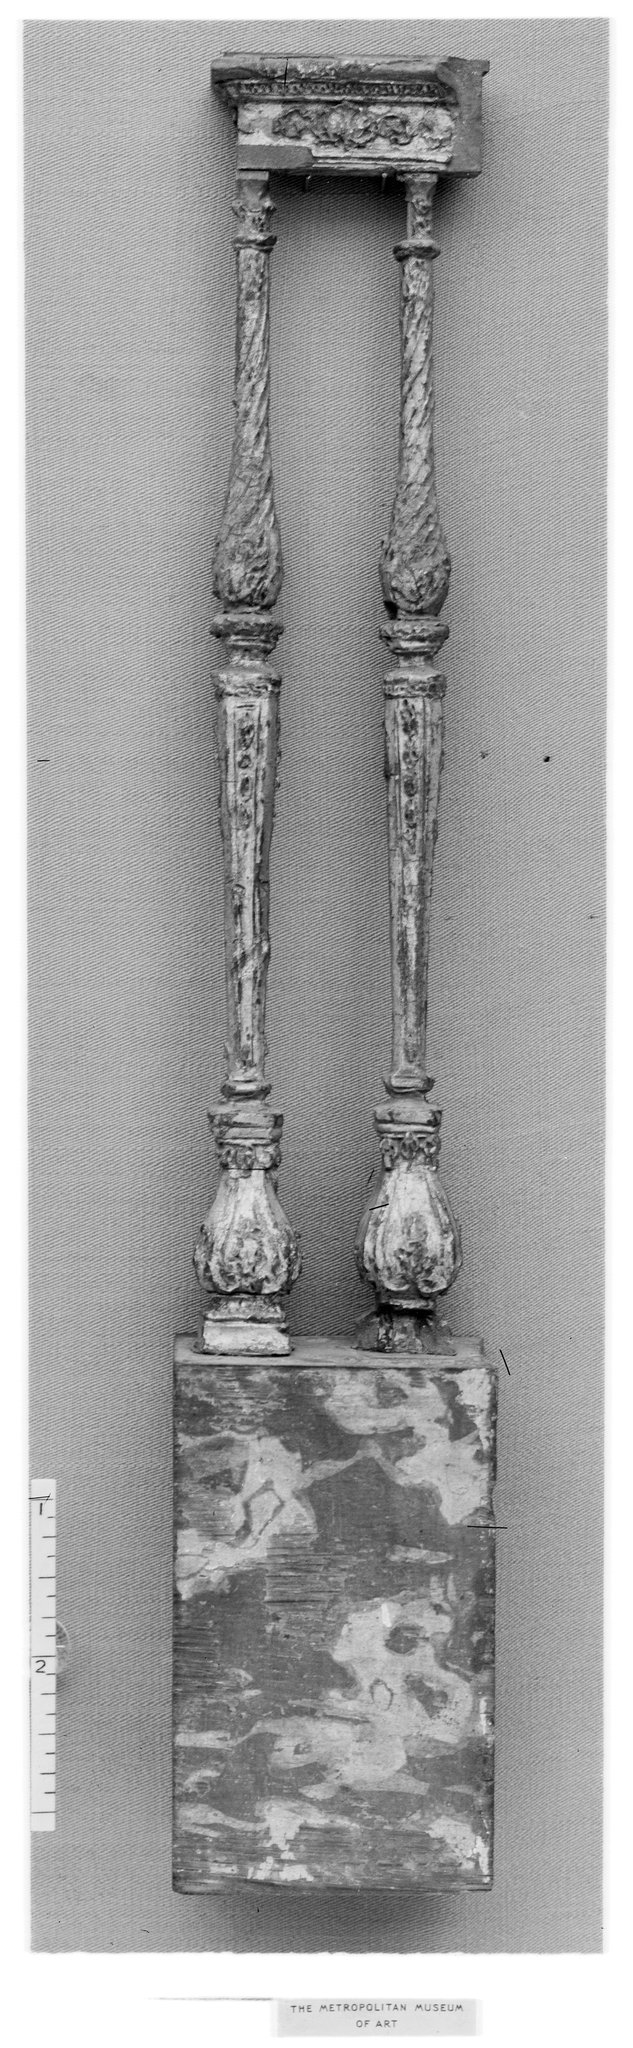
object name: balustrade fragment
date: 1667-1733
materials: gilt, wood